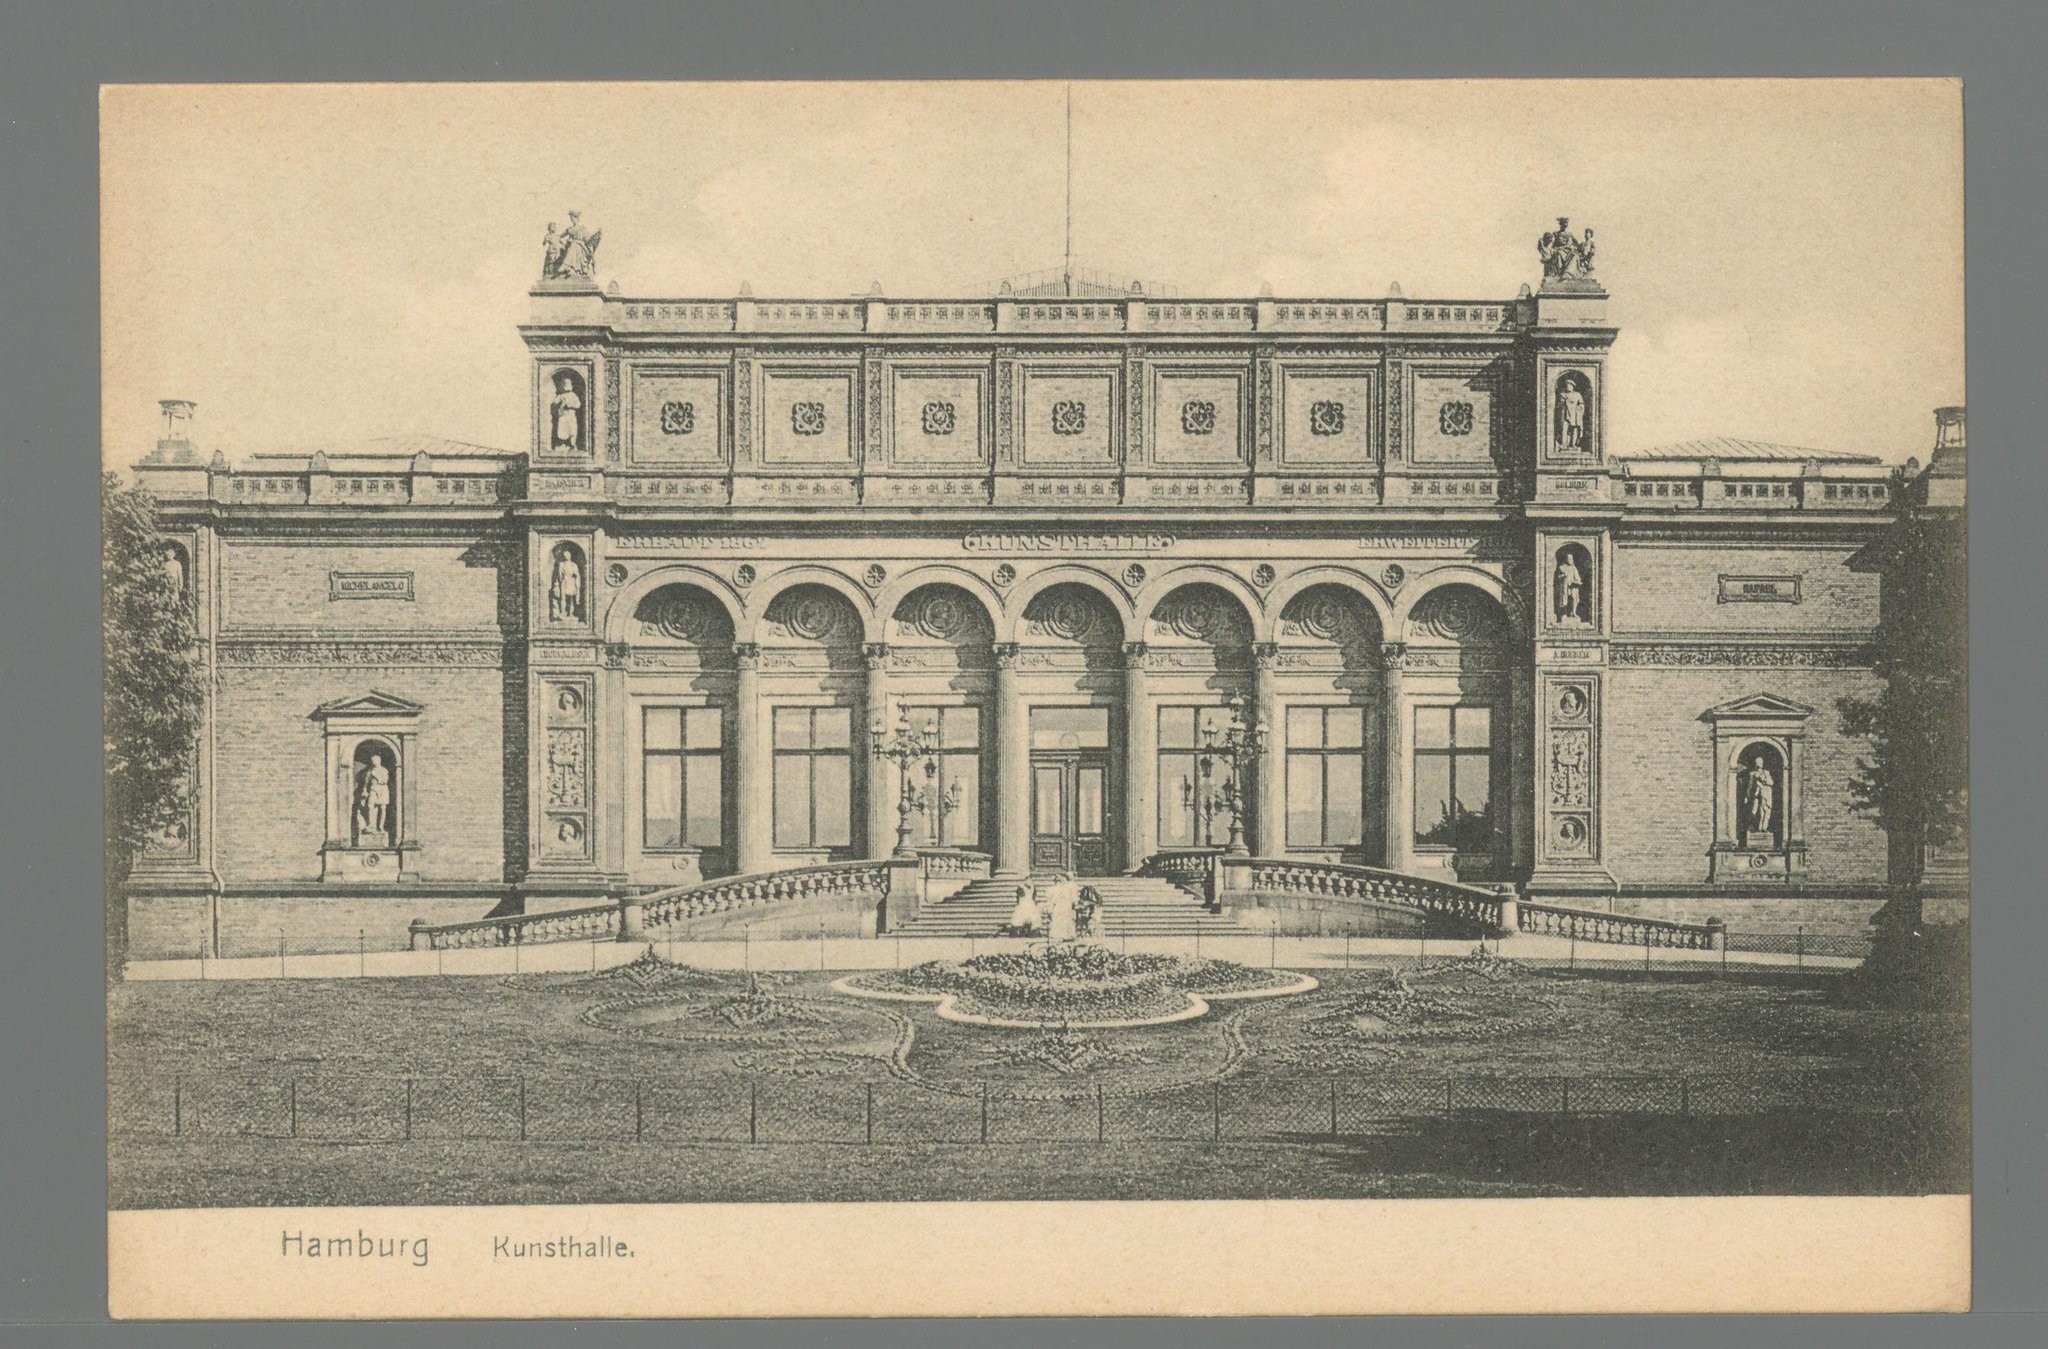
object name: photomechanical print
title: Hamburg. Kunsthalle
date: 1905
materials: cardboard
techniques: photograph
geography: hamburg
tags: permanent exhibition, museum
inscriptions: date